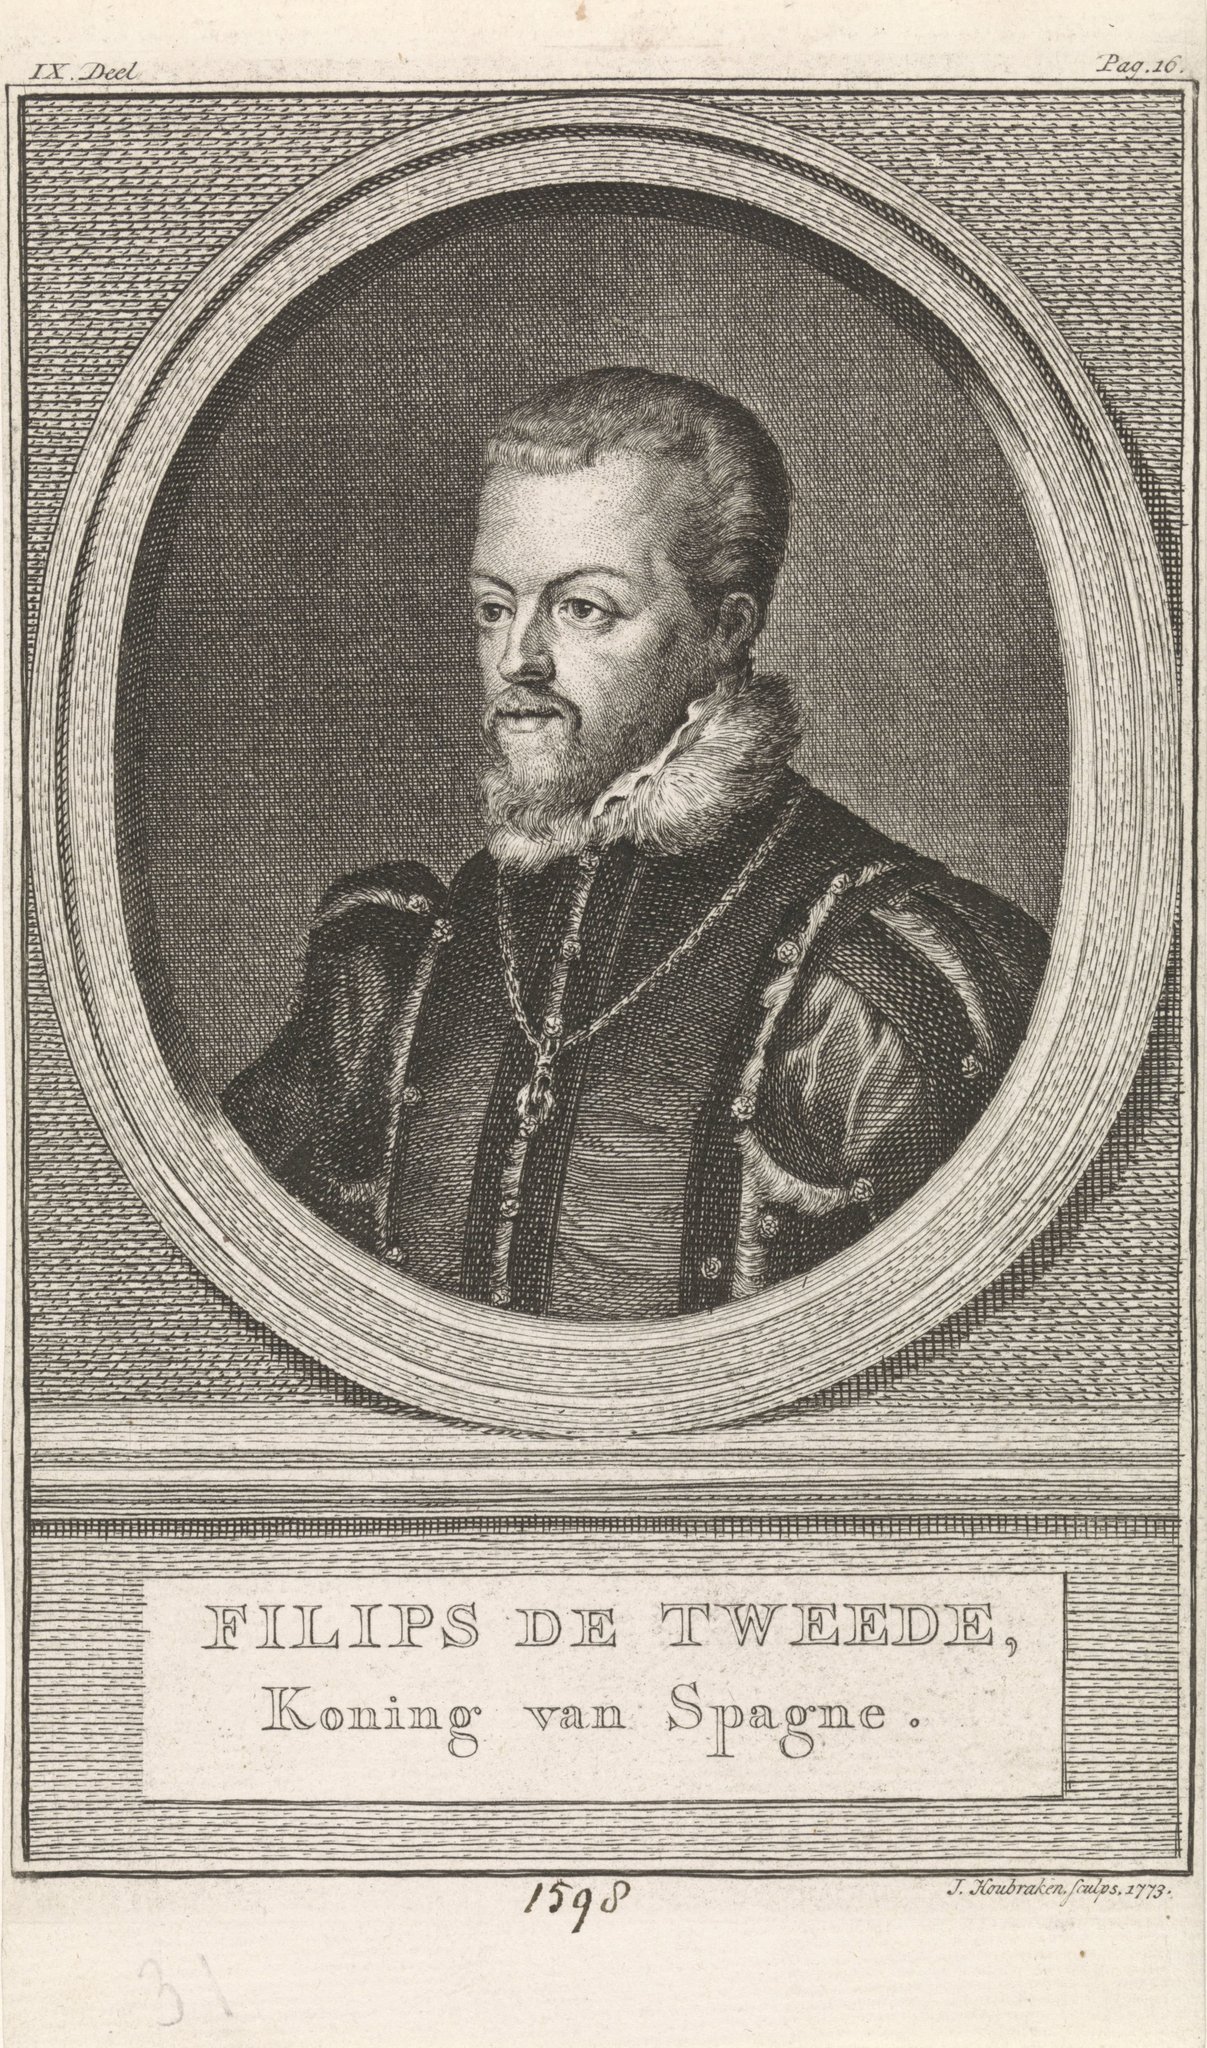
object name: print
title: Filips de Tweede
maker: jacob houbraken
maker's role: draughtsman, print maker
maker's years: 1698-1780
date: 1773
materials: paper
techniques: engraving, pen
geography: amsterdam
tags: philip ii of spain, historical persons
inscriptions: collector's mark: Lugt 2228, date: ‘1598’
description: Prent ook gebruikt in: Jan Wagenaar, Vaderlandsche historie, vervattende de geschiedenissen der nu Vereenigde Nederlanden, inzonderheid die van Holland (...), 21 delen. Amsterdam, Johannes Allart, 1790-96.